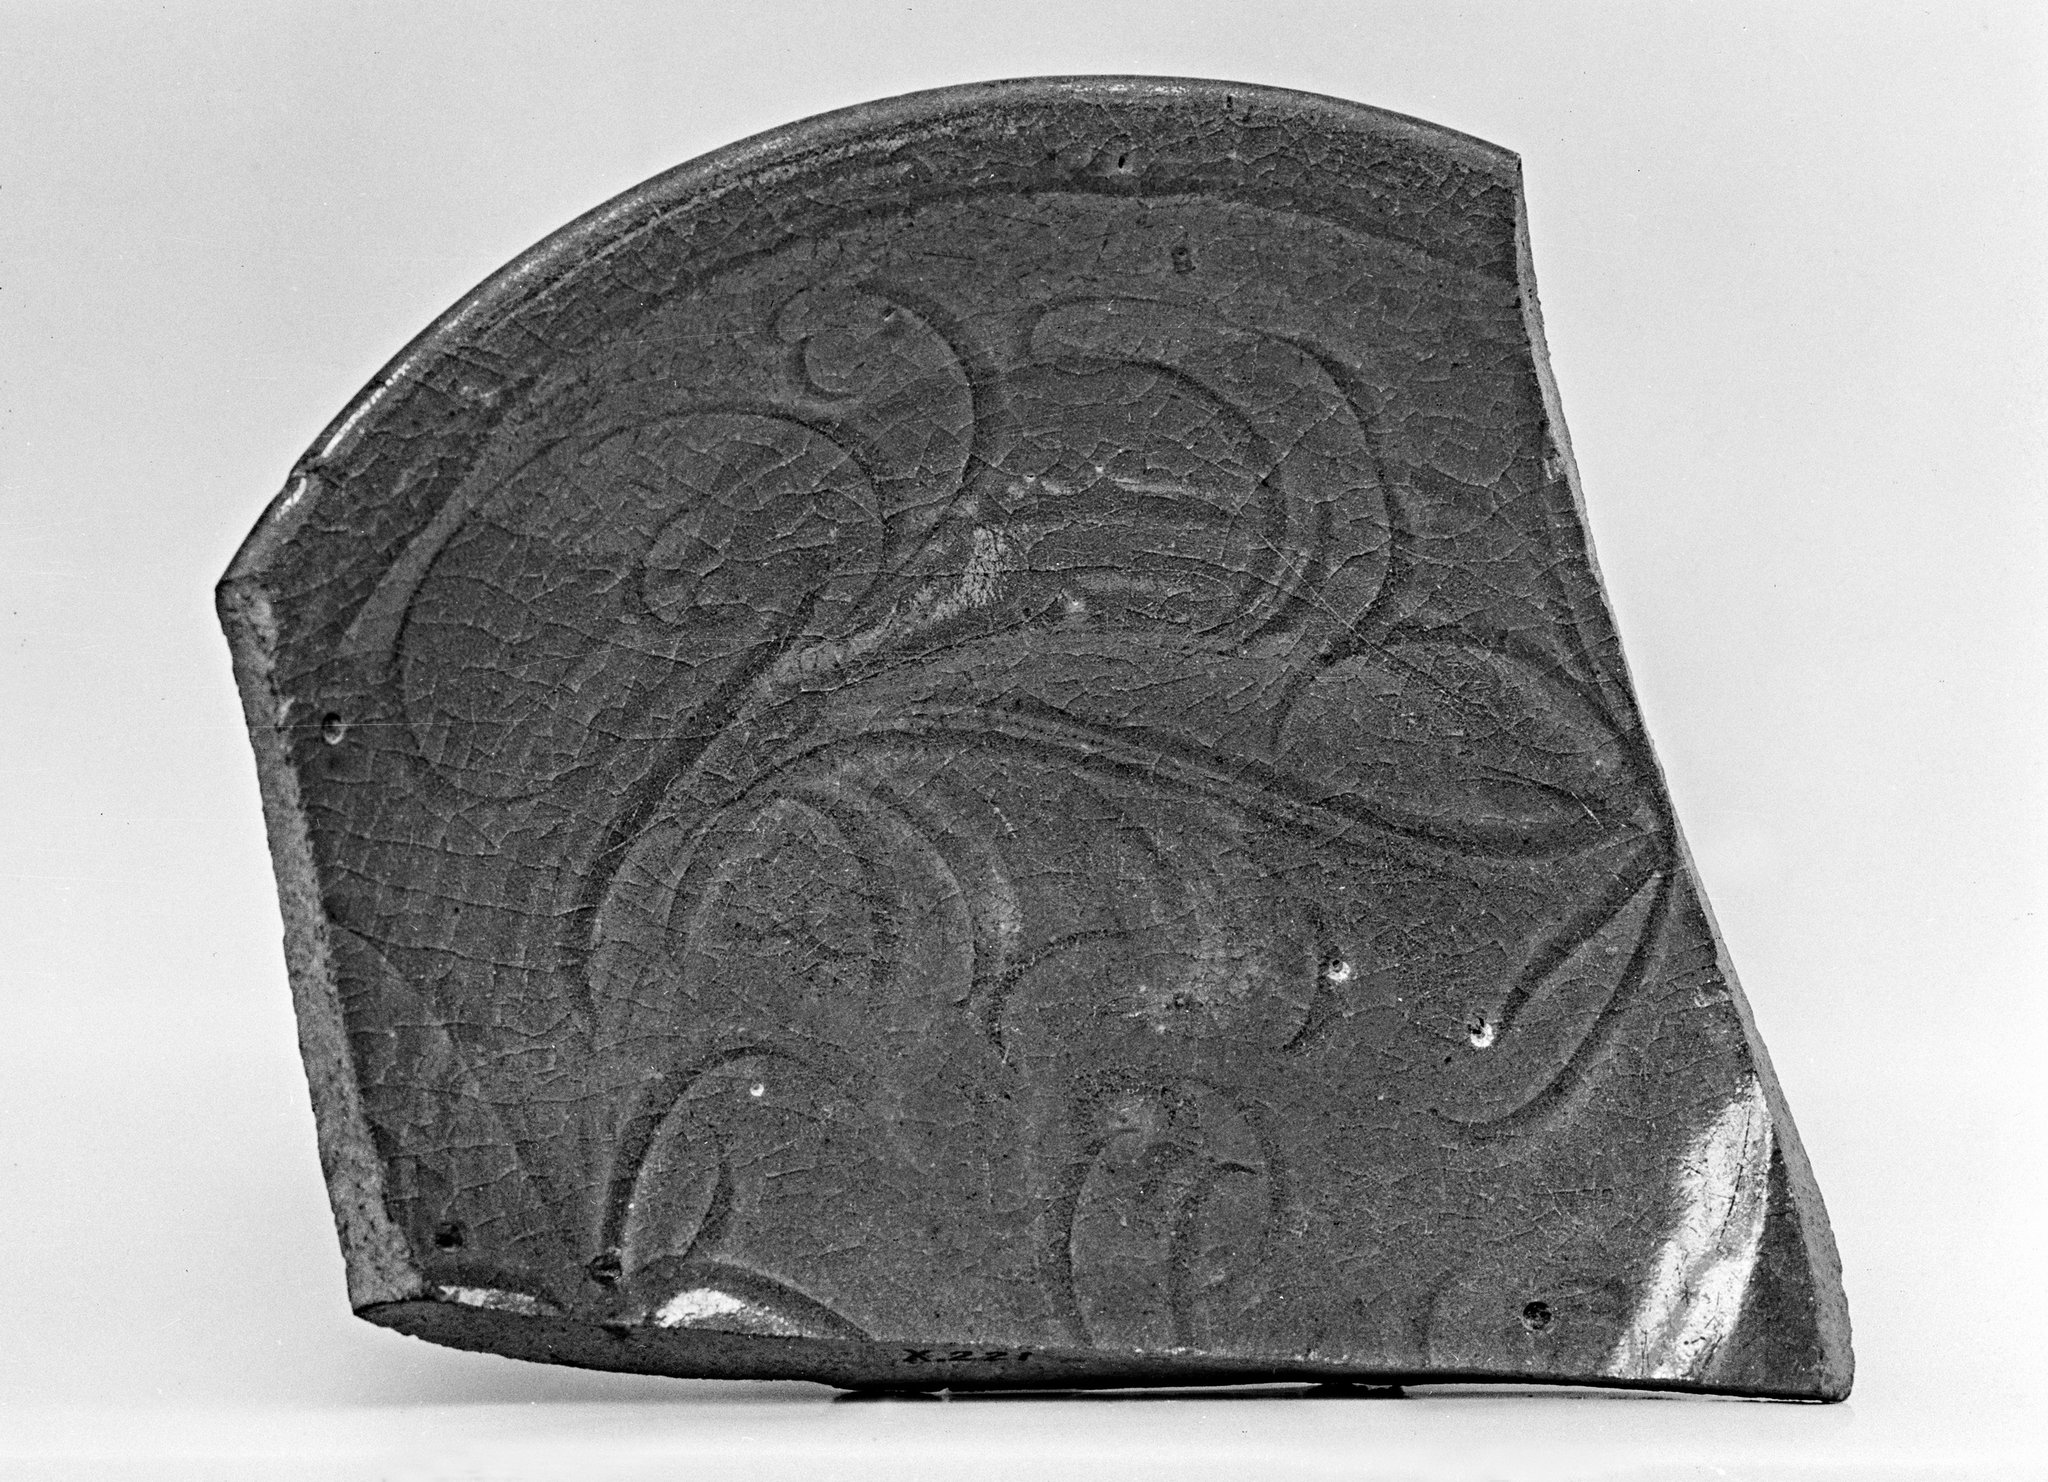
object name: fragment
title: Fragment of a Bowl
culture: chinese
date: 960-1279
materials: ceramic glaze, glaze, stoneware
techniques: incising